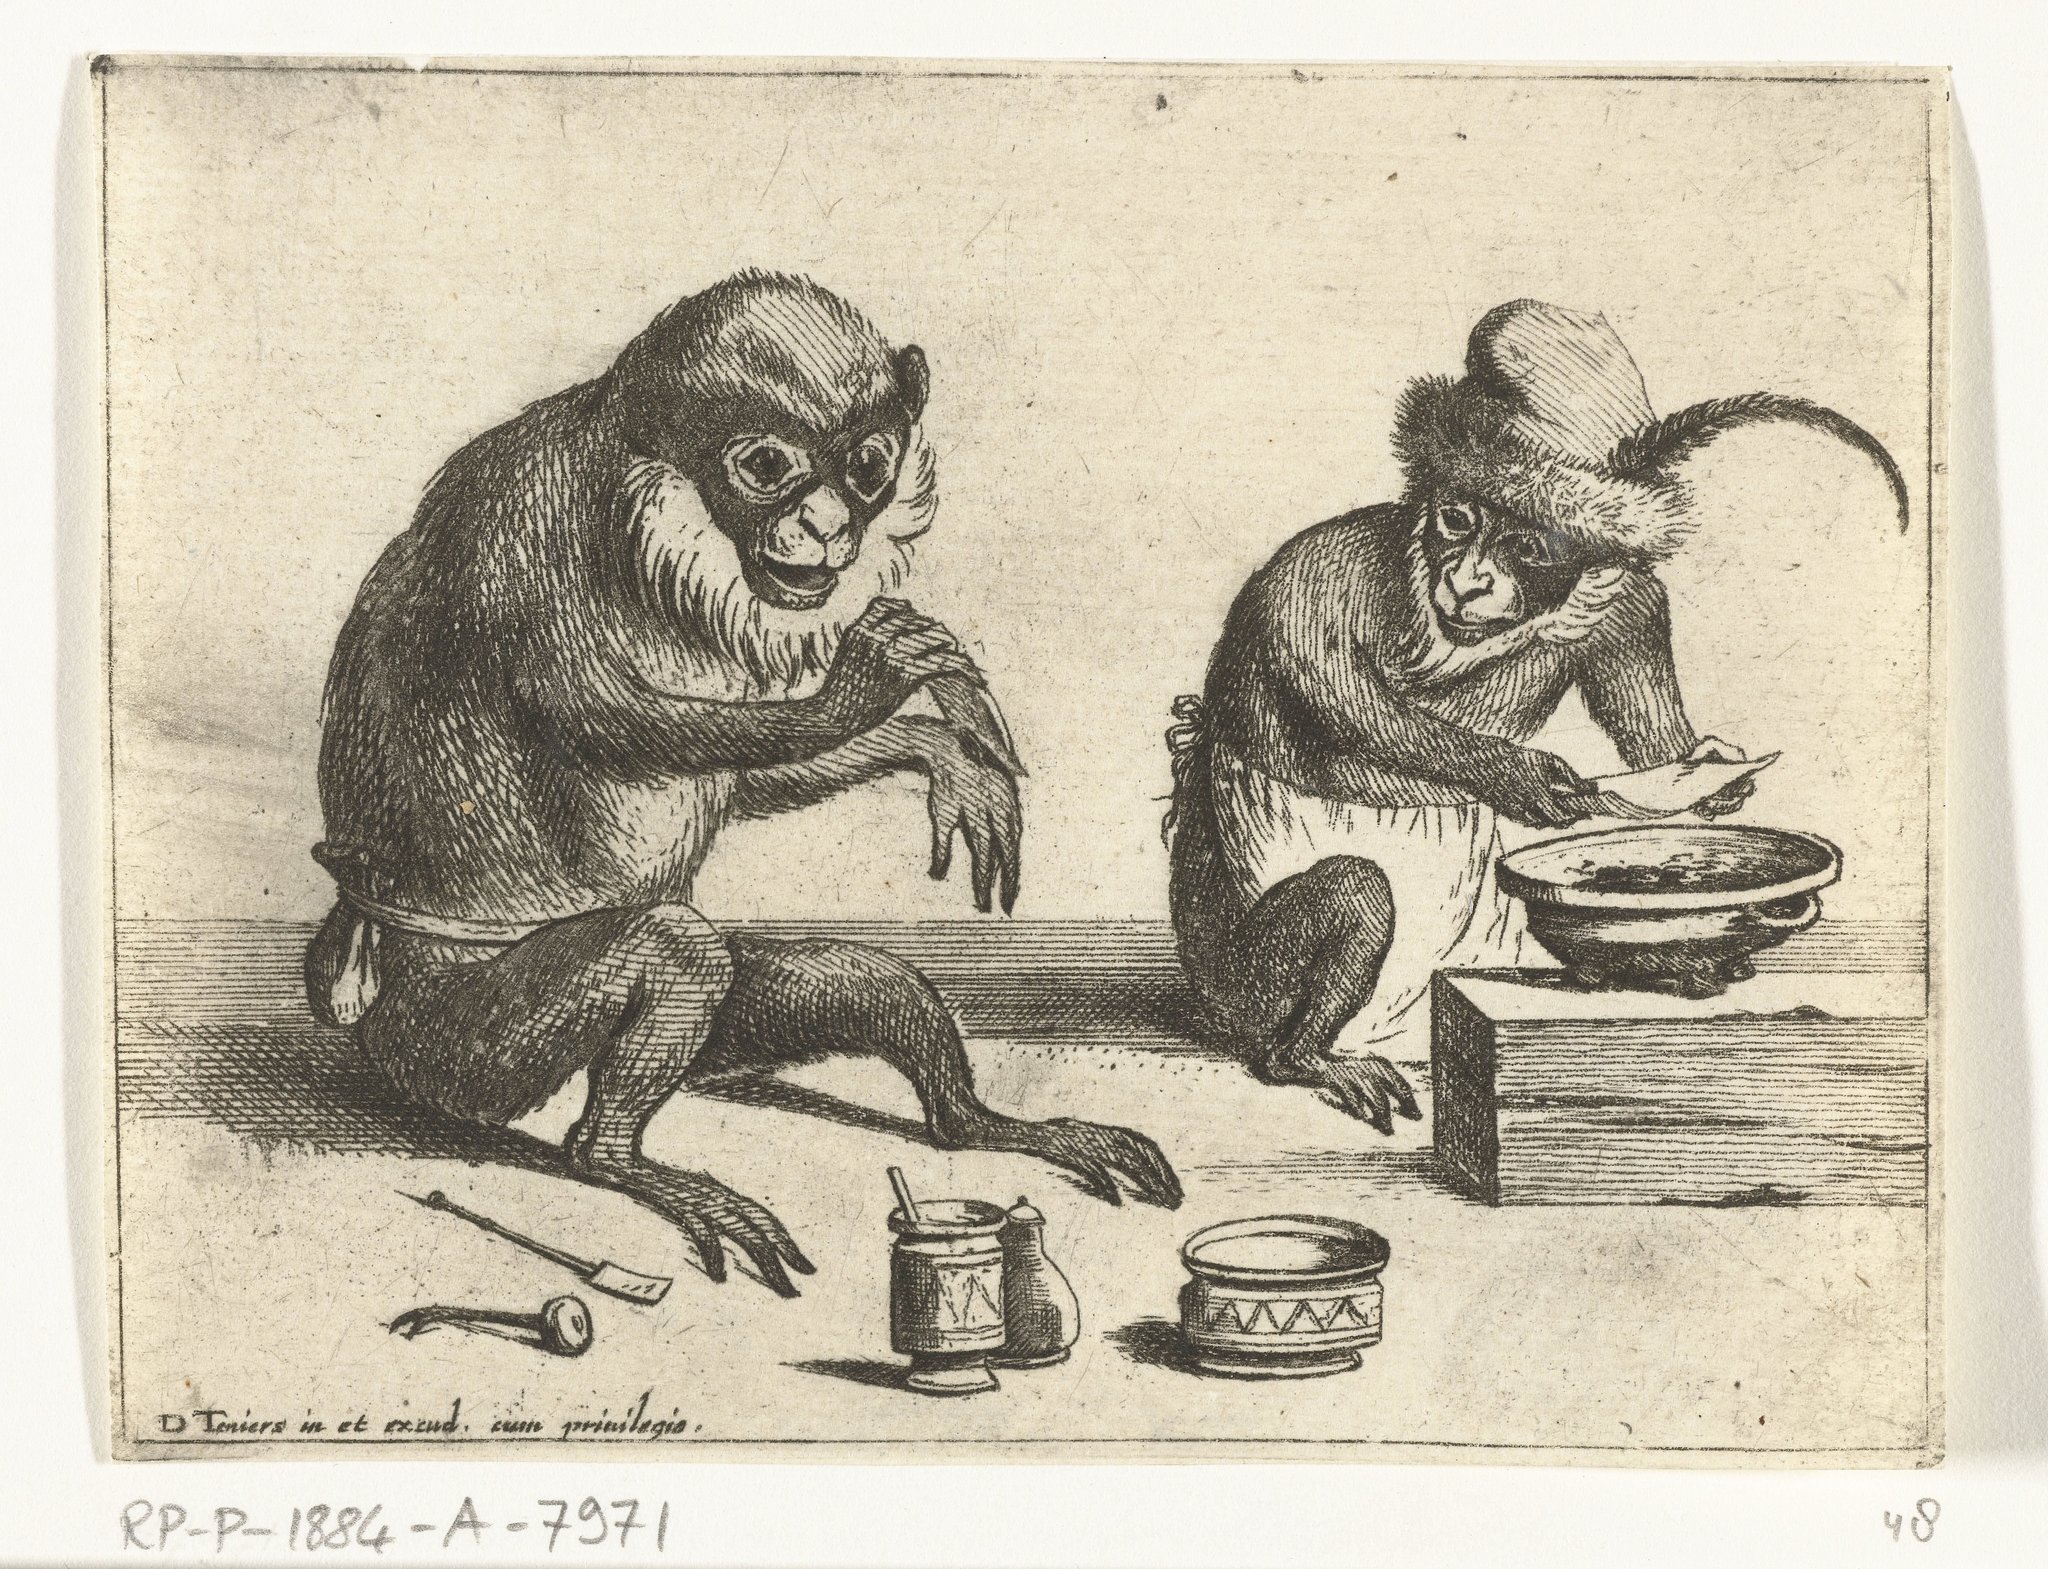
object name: print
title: Verschillende bedrijven uit het menselijke leven door apen voorgesteld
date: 1635-1690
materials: paper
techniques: etching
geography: southern netherlands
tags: animals acting as human beings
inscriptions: collector's mark: Lugt 2228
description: Twee apen zitten op de grond, een aap verwarmt verbandmateriaal boven een vuurpot. De andere legt zichzelf een verband om zijn pols. Op de voorgrond staan potten met zalf. Prent uit een serie van zes prenten en een titelprent waarin verschillende menselijke bezigheden door apen voorgesteld worden.